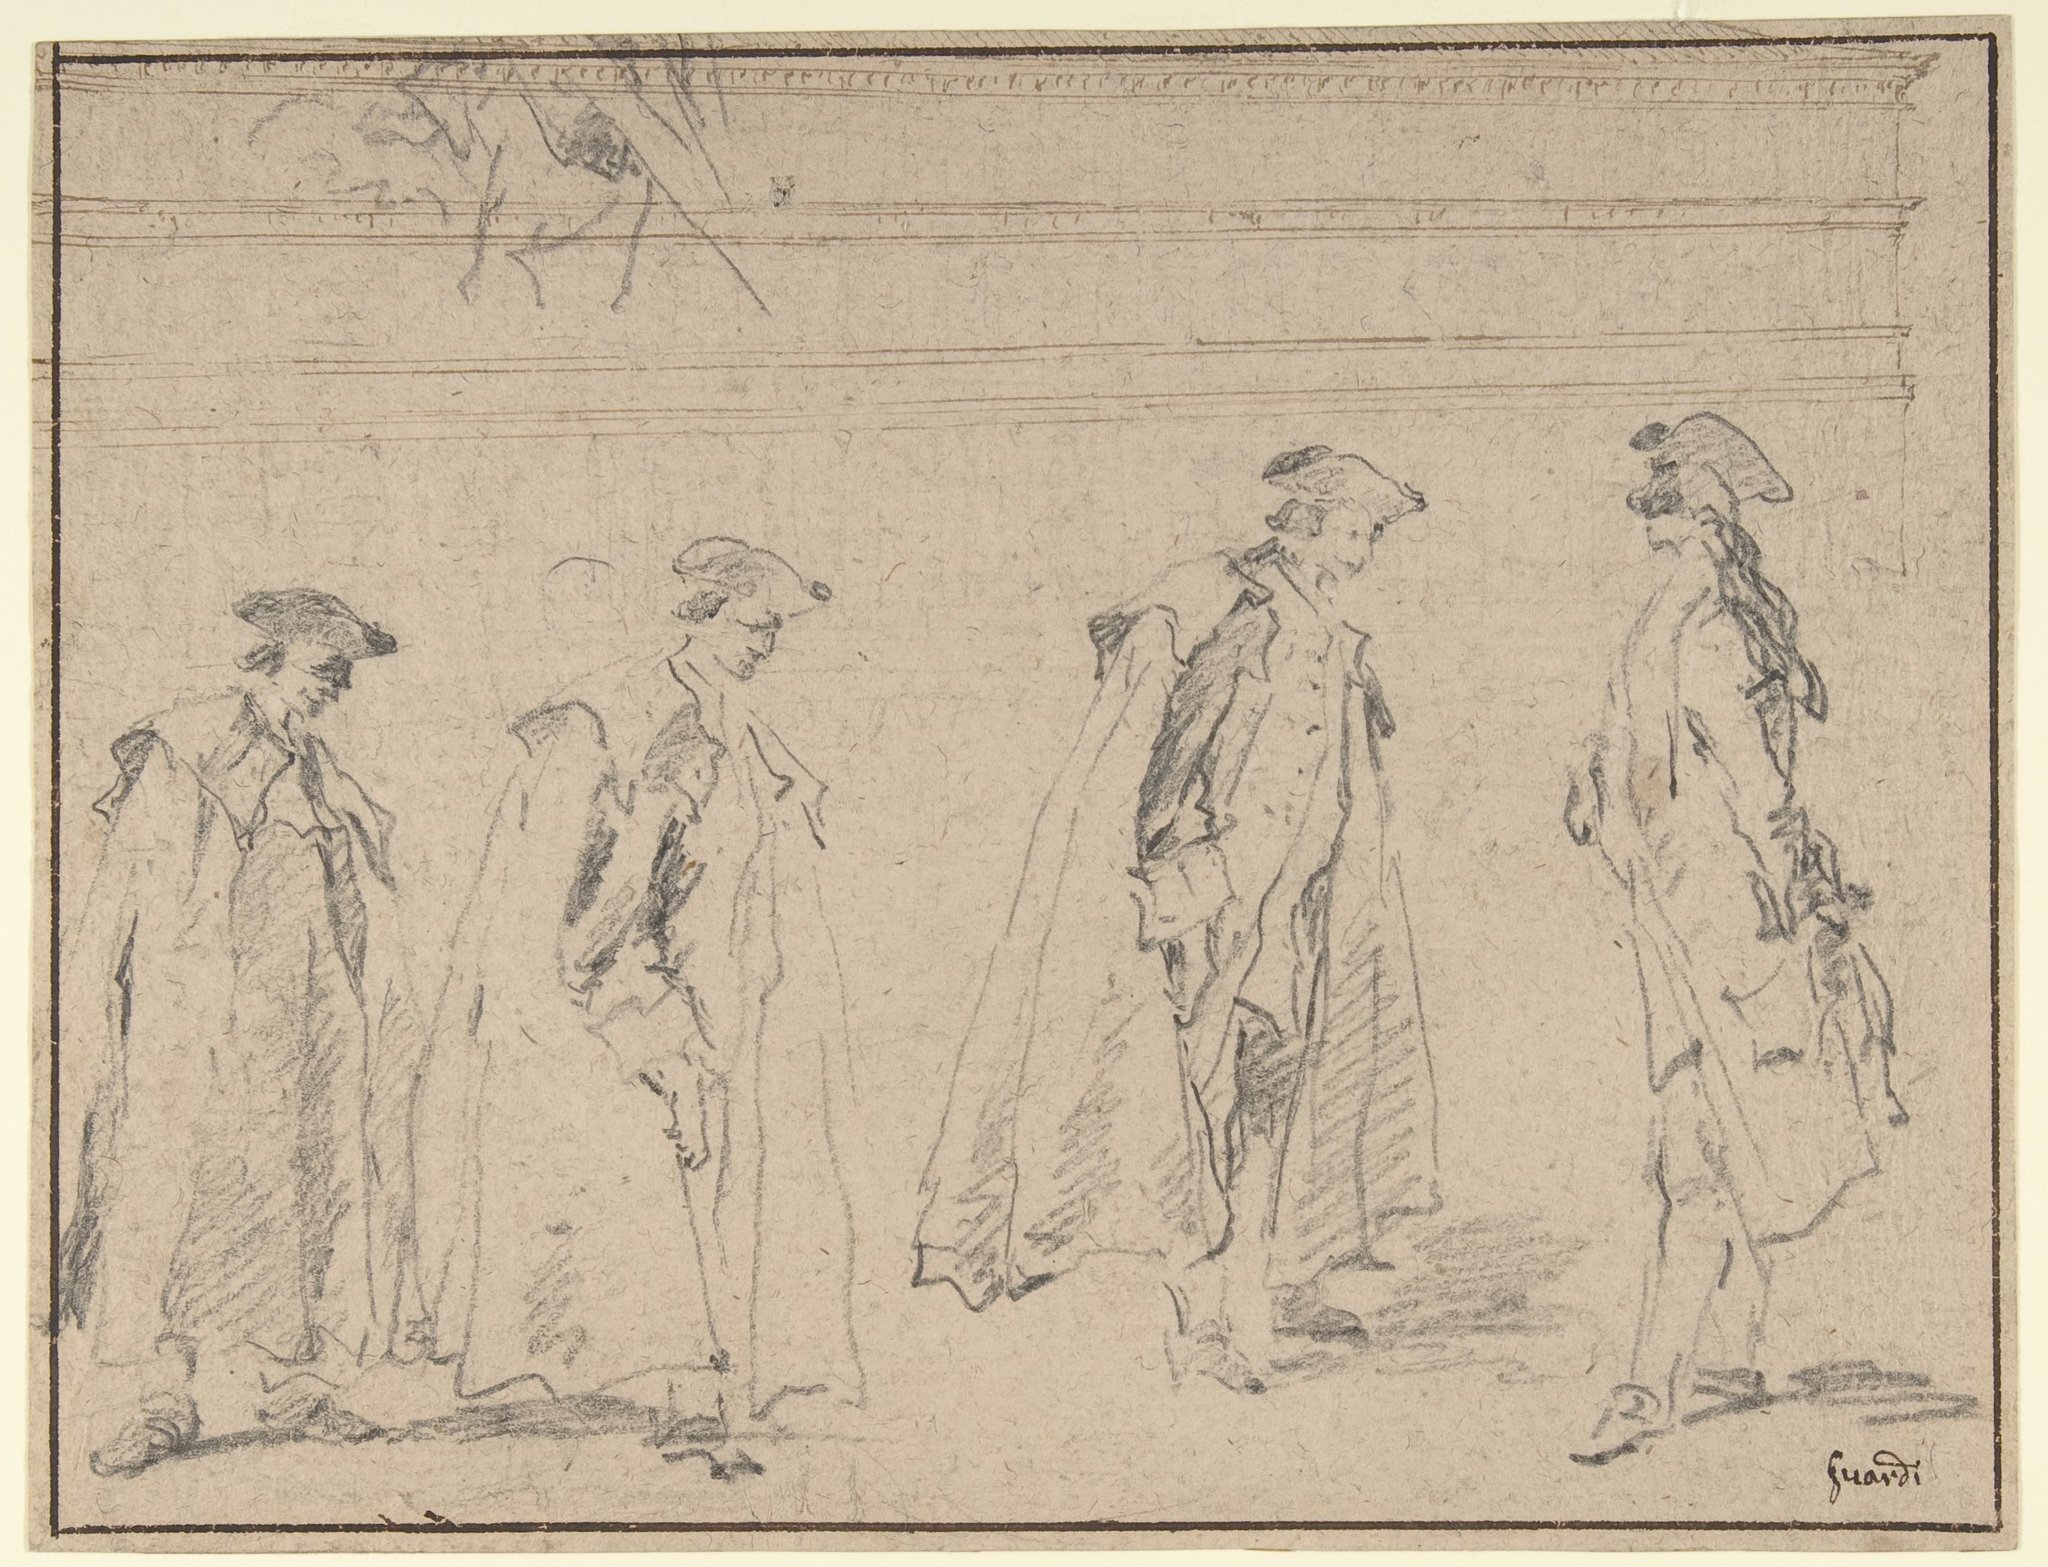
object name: drawing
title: Figure Studies (recto); Figures Along a Canal and on a Bridge; to the right, a Curtain and a Stool (?) (verso)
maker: francesco guardi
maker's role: artist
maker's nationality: italian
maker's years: 1712-1793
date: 1712-1793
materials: chalk, ink, paper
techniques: pen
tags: men